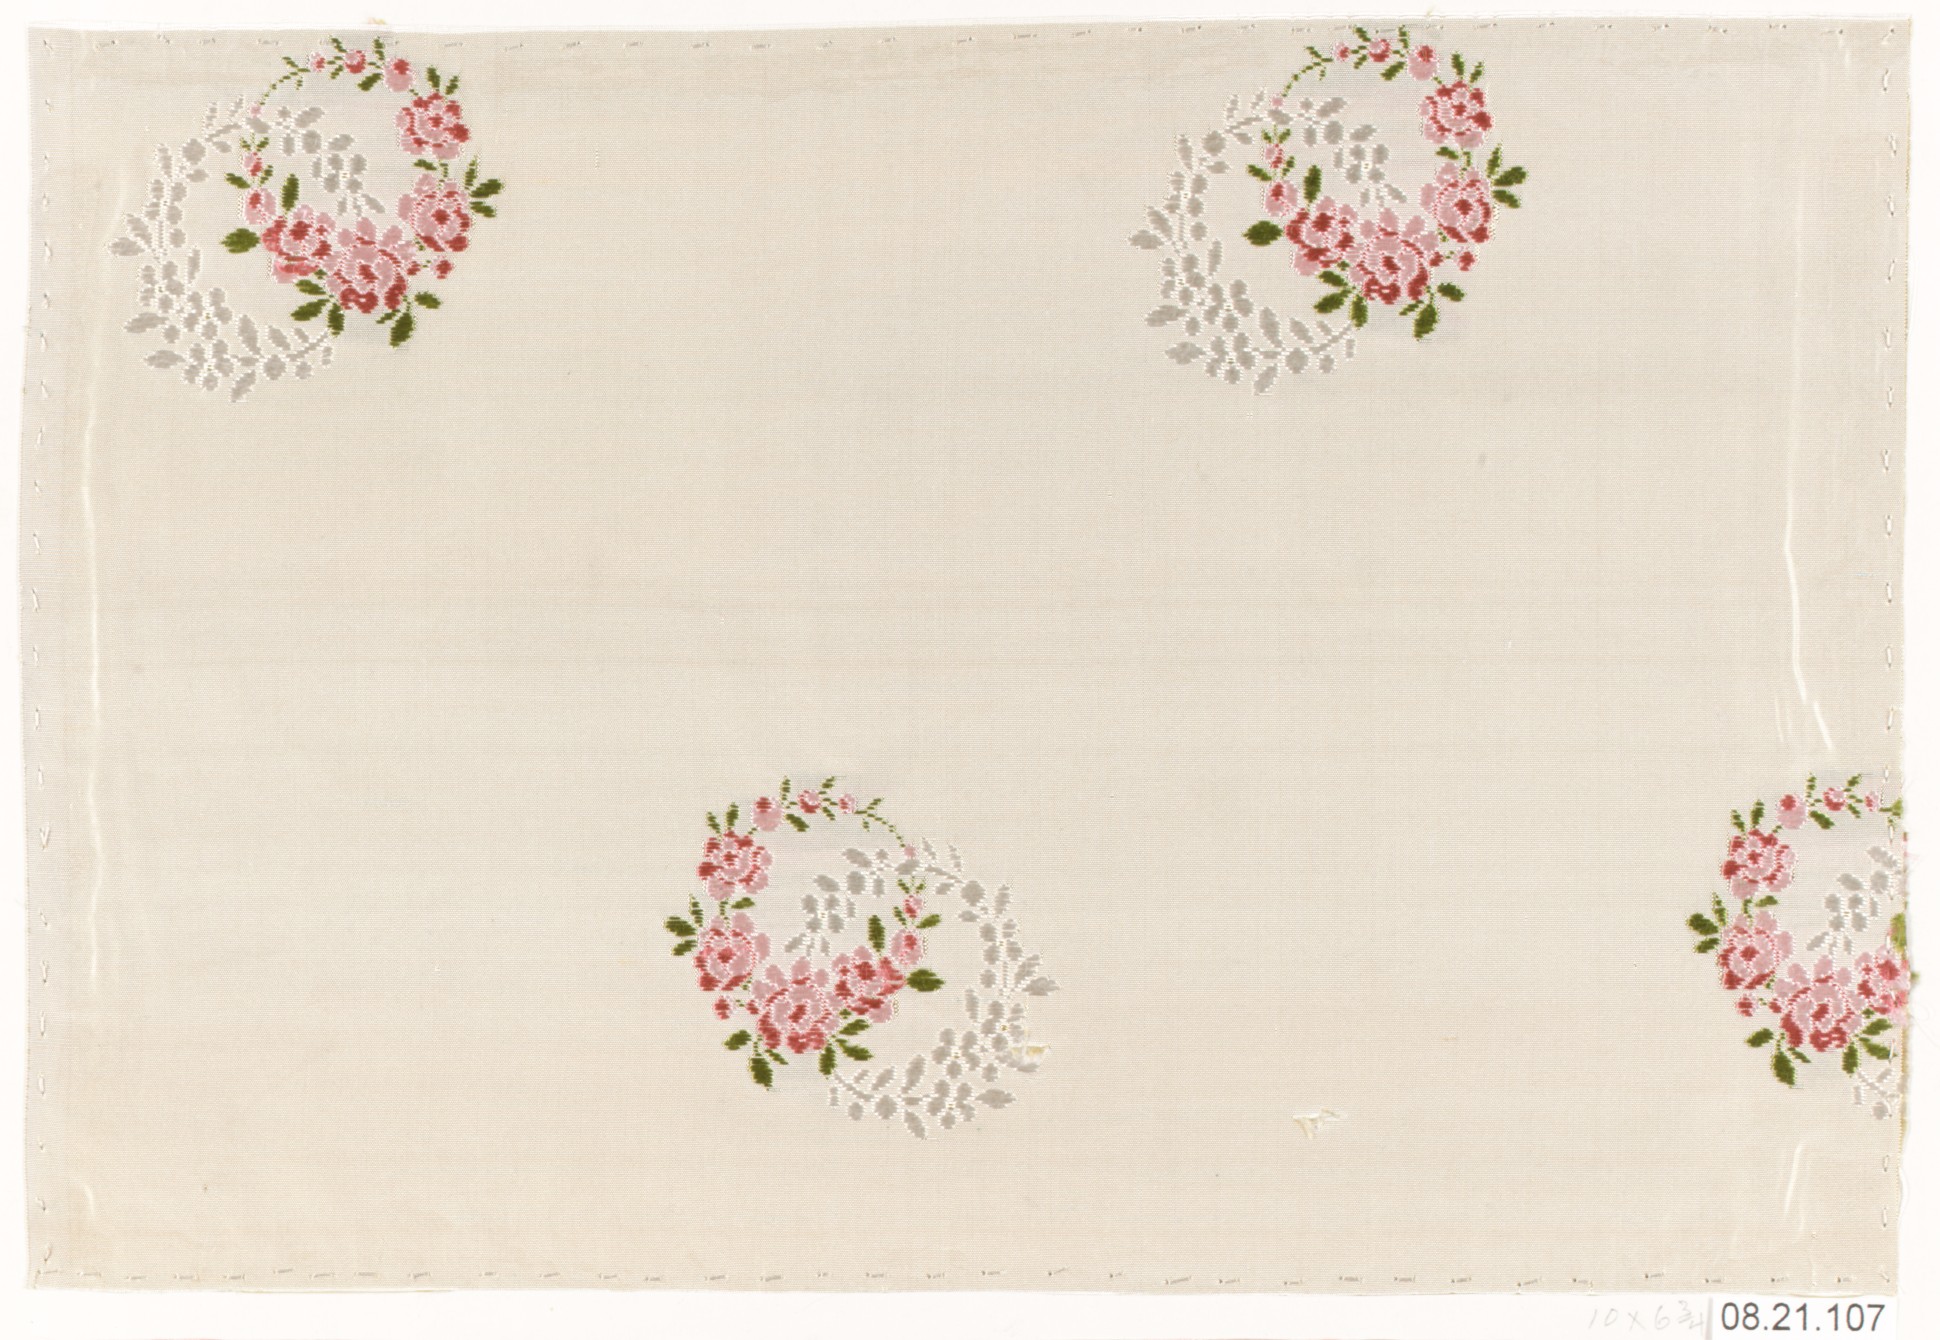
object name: textile sample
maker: Anonymous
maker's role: designer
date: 1900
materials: silk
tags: flowers